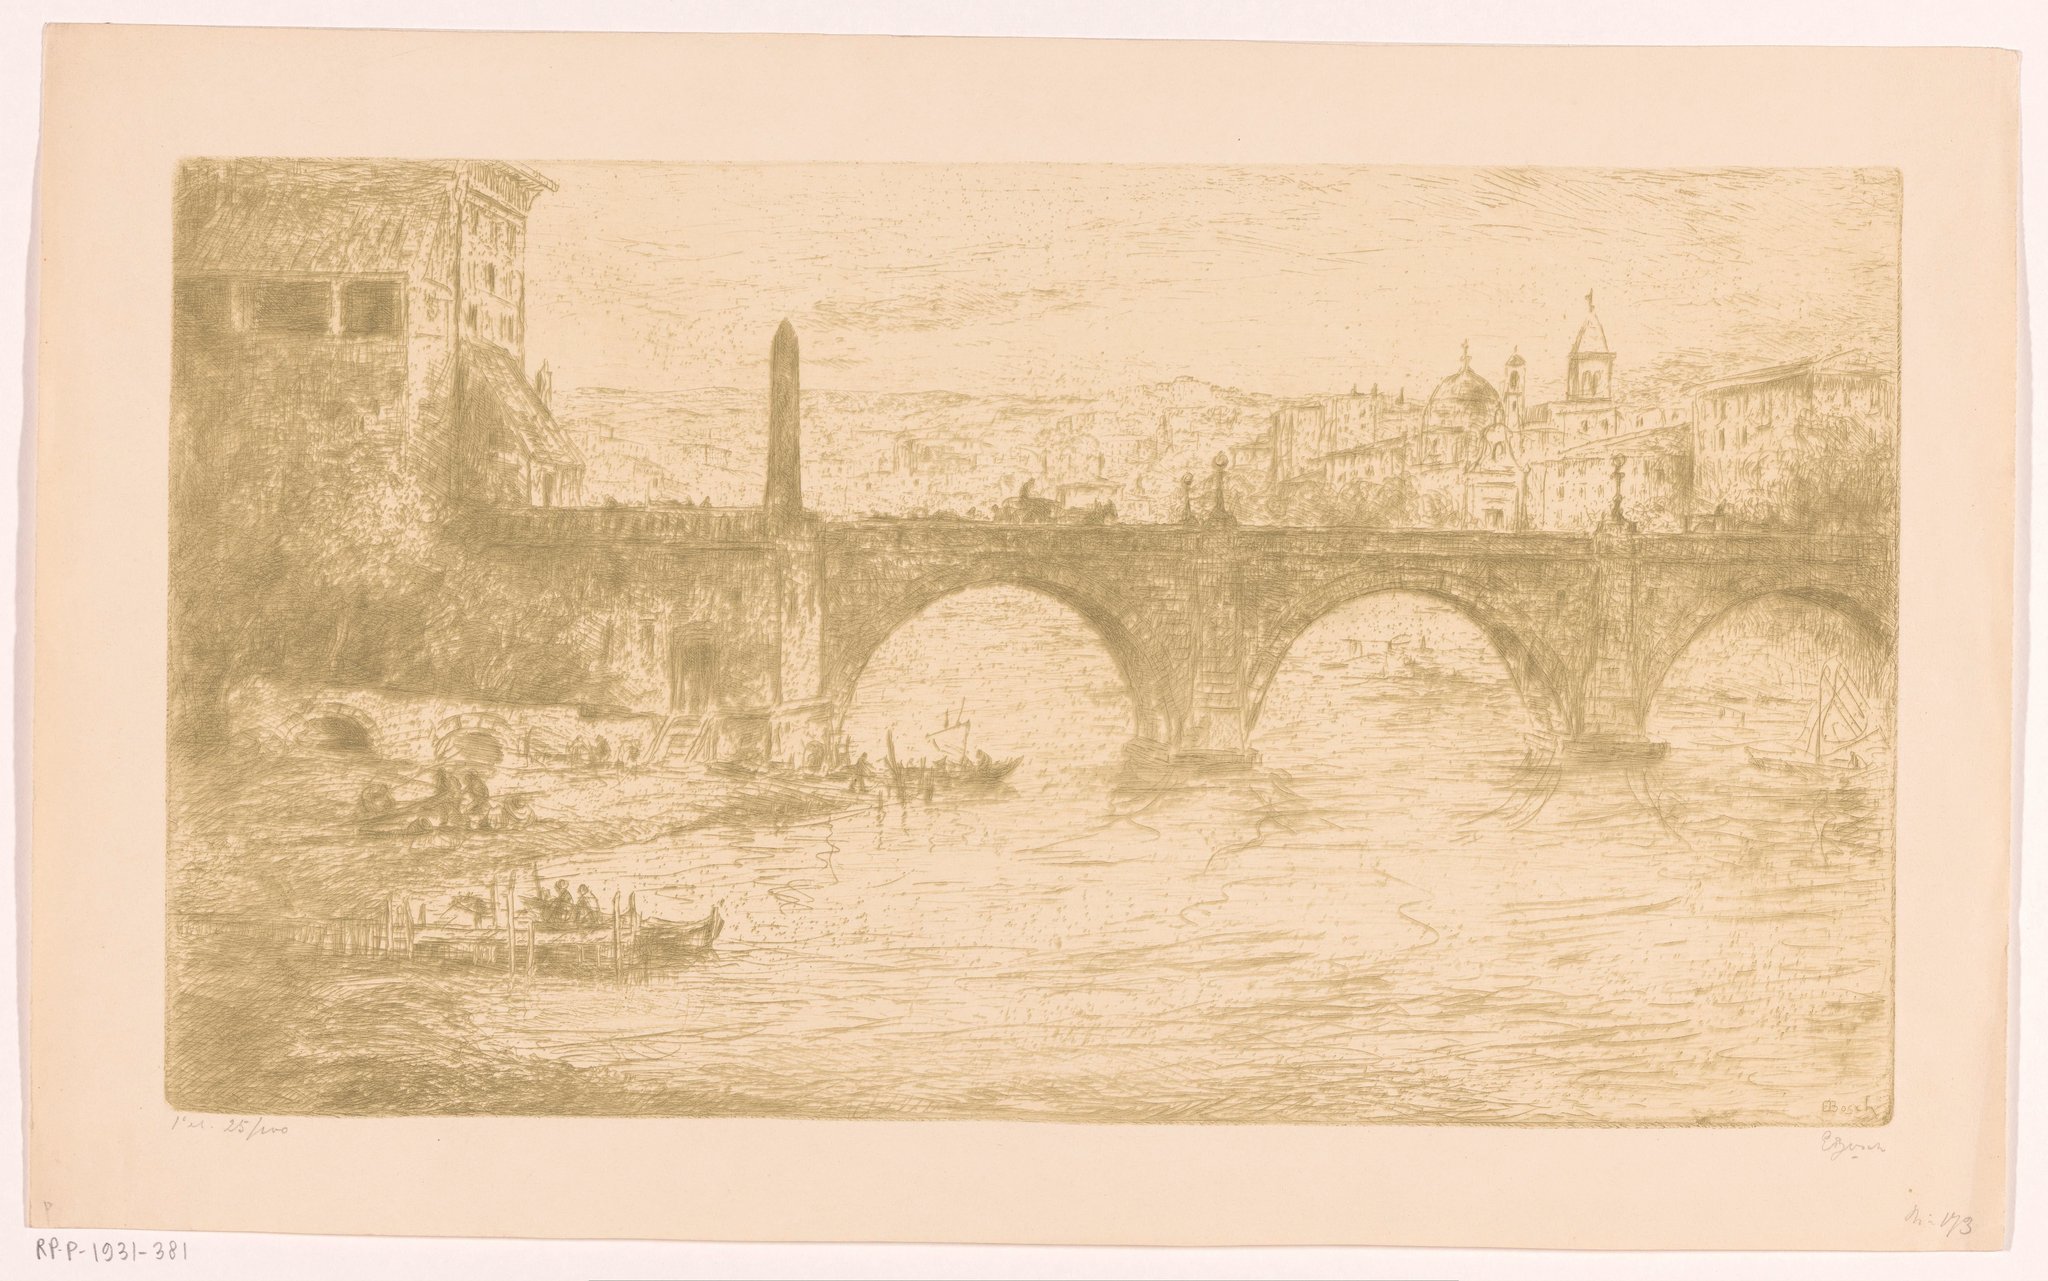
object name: print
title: Brug in Rome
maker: etienne bosch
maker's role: print maker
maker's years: 1863-1933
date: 1873-1931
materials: paper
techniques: etching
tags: bridge in city across river, canal, etc., rome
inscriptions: number: ‘no. 173’, collector's mark: Lugt 2228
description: Zicht op drie bogen van een brug over een rivier in Rome. Links op de brug een zuil.